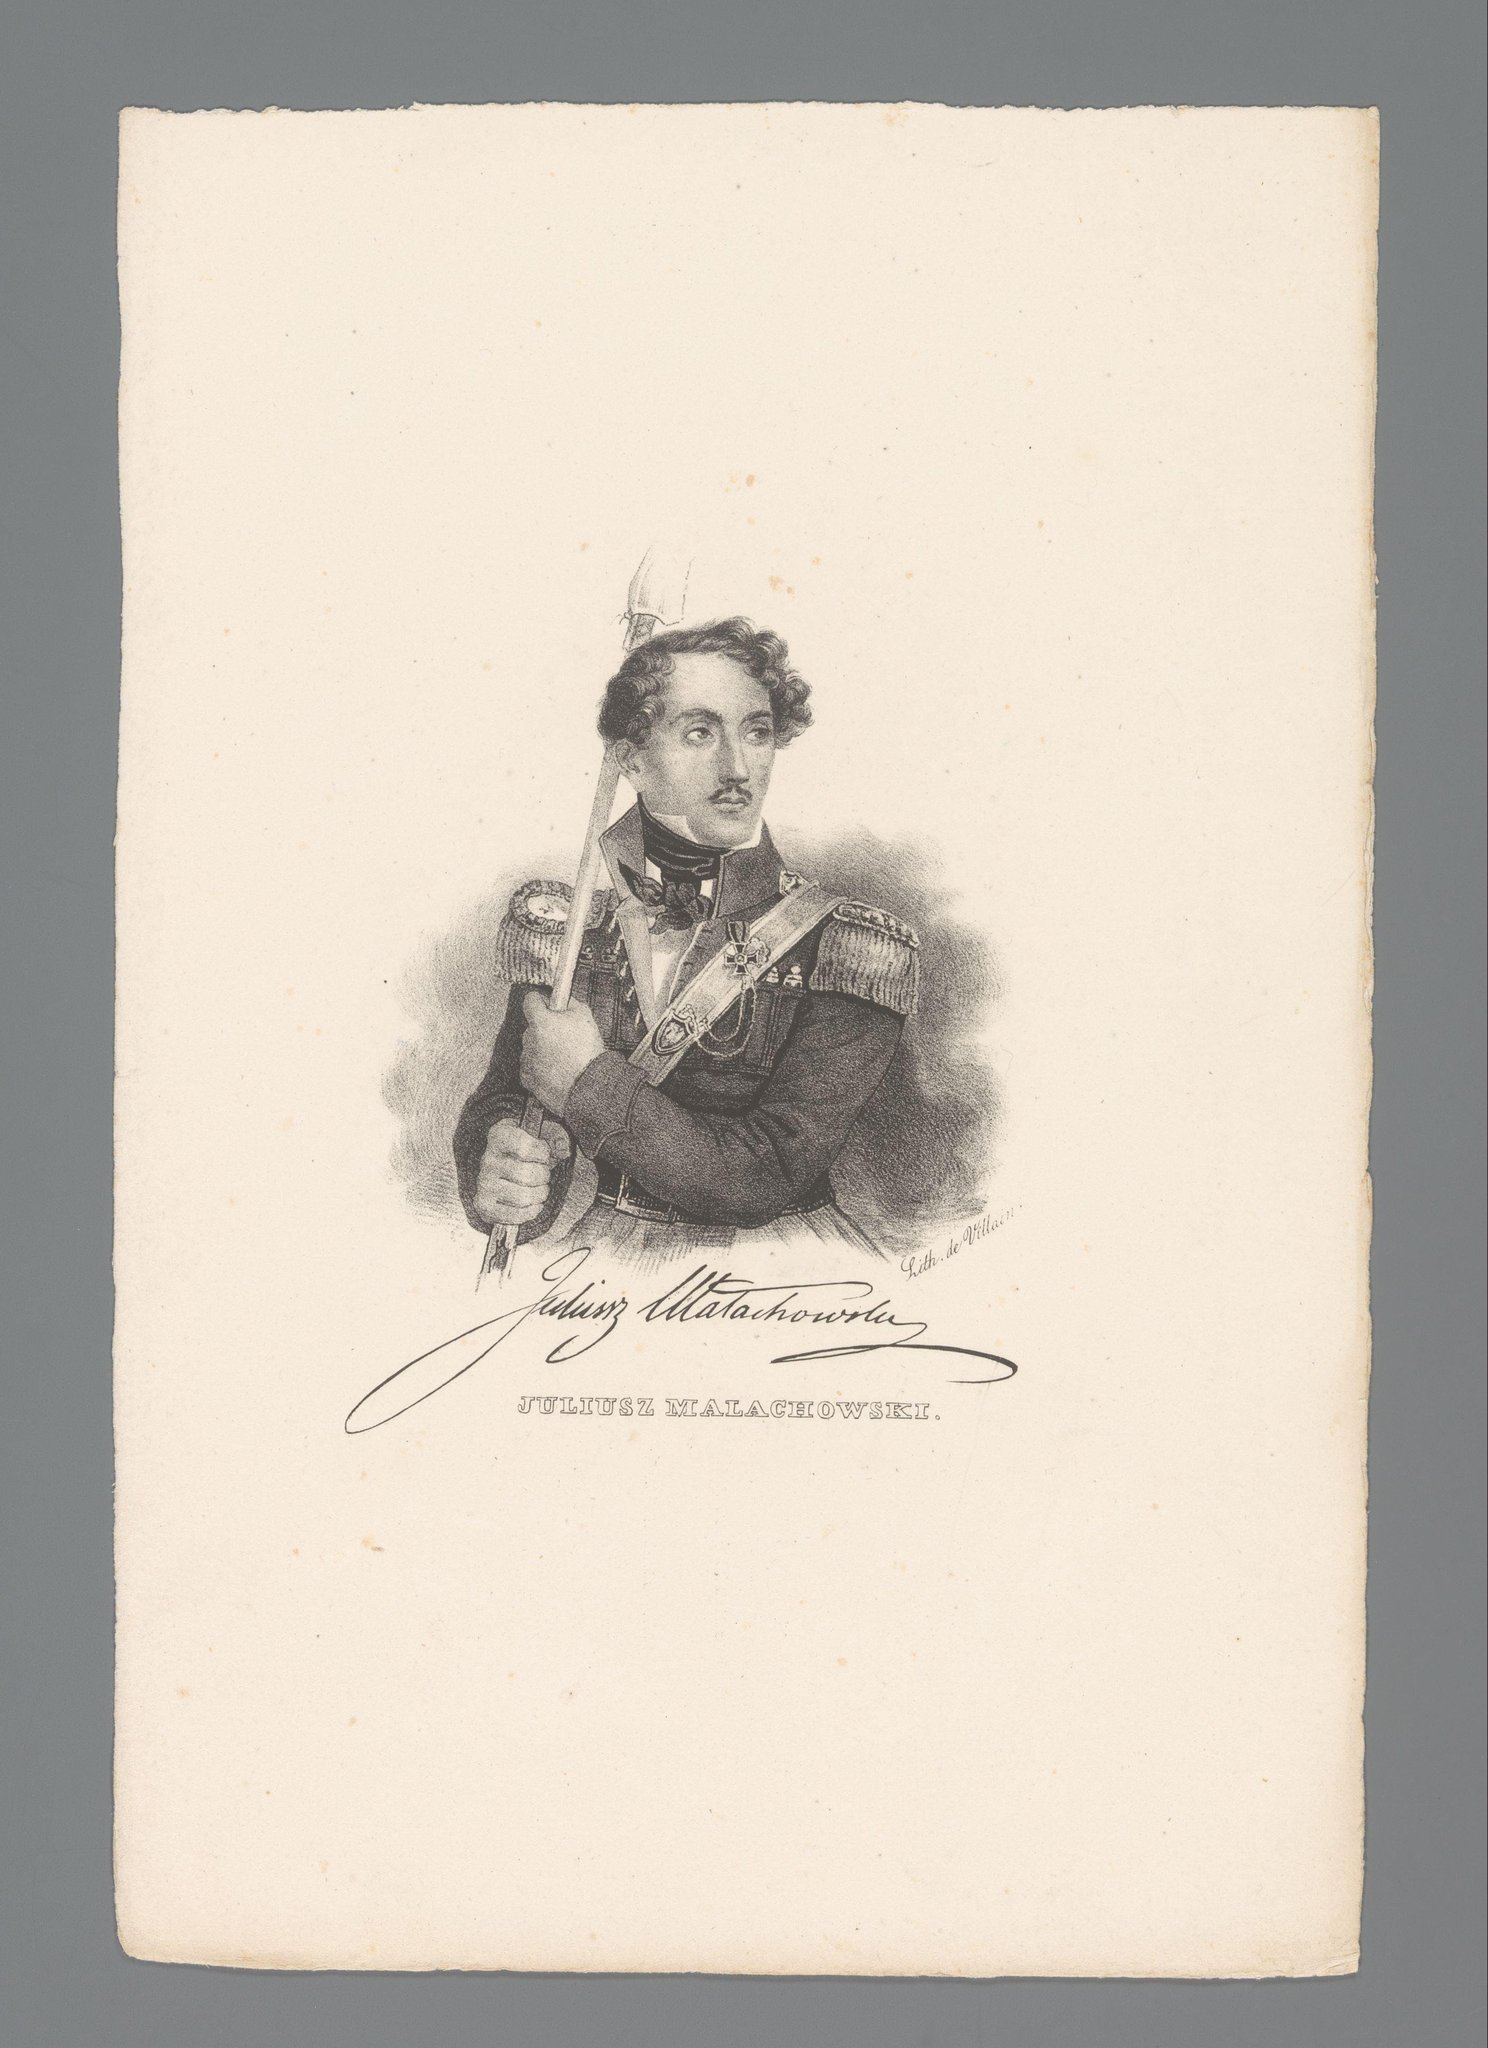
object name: print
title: Juliusz Malachowski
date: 1832-1839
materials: paper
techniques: lithograph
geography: paris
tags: historical persons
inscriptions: collector's mark: Lugt 2228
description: Prent uit: Straszewicz., Joseph. Les polonais et les polonaises de la révolution du 29 novembre 1830, ou Portraits des personnes qui ont figuré dans la dernière guerre de l'indépendance polonaise, avec les fac-simile de leur signature, lithographiés sur dessins originaux, par les artistes les plus distingués: MM. Grévedon, Maurin, Vigneron, Belliard, Devéria, Bazin, Desmadryl, Lecler, Desmaisons, Rutowski, officier polonais, etc,. etc., accompagnés d'une biographie pour chaque portrait. Parijs: Catherine-Anaïs Pinard, 1832. Of uit: Straszewicz., Joseph. Les polonais et les polonaises de la révolution du 29 novembre 1830. Biographie des personnes qui ont figuré dans la dernière guerre de l'indépendance polonaise, avec les fac-simile de leur signature, ornée de 30 portraits lithographiés sur dessins originaux, par les artistes les plus distingués: MM. Grévedon, Maurin, Vigneron, Belliard, Devéria, Bazin, Desmadryl, Lecler, etc., etc.. Parijs: s.n., 1839.